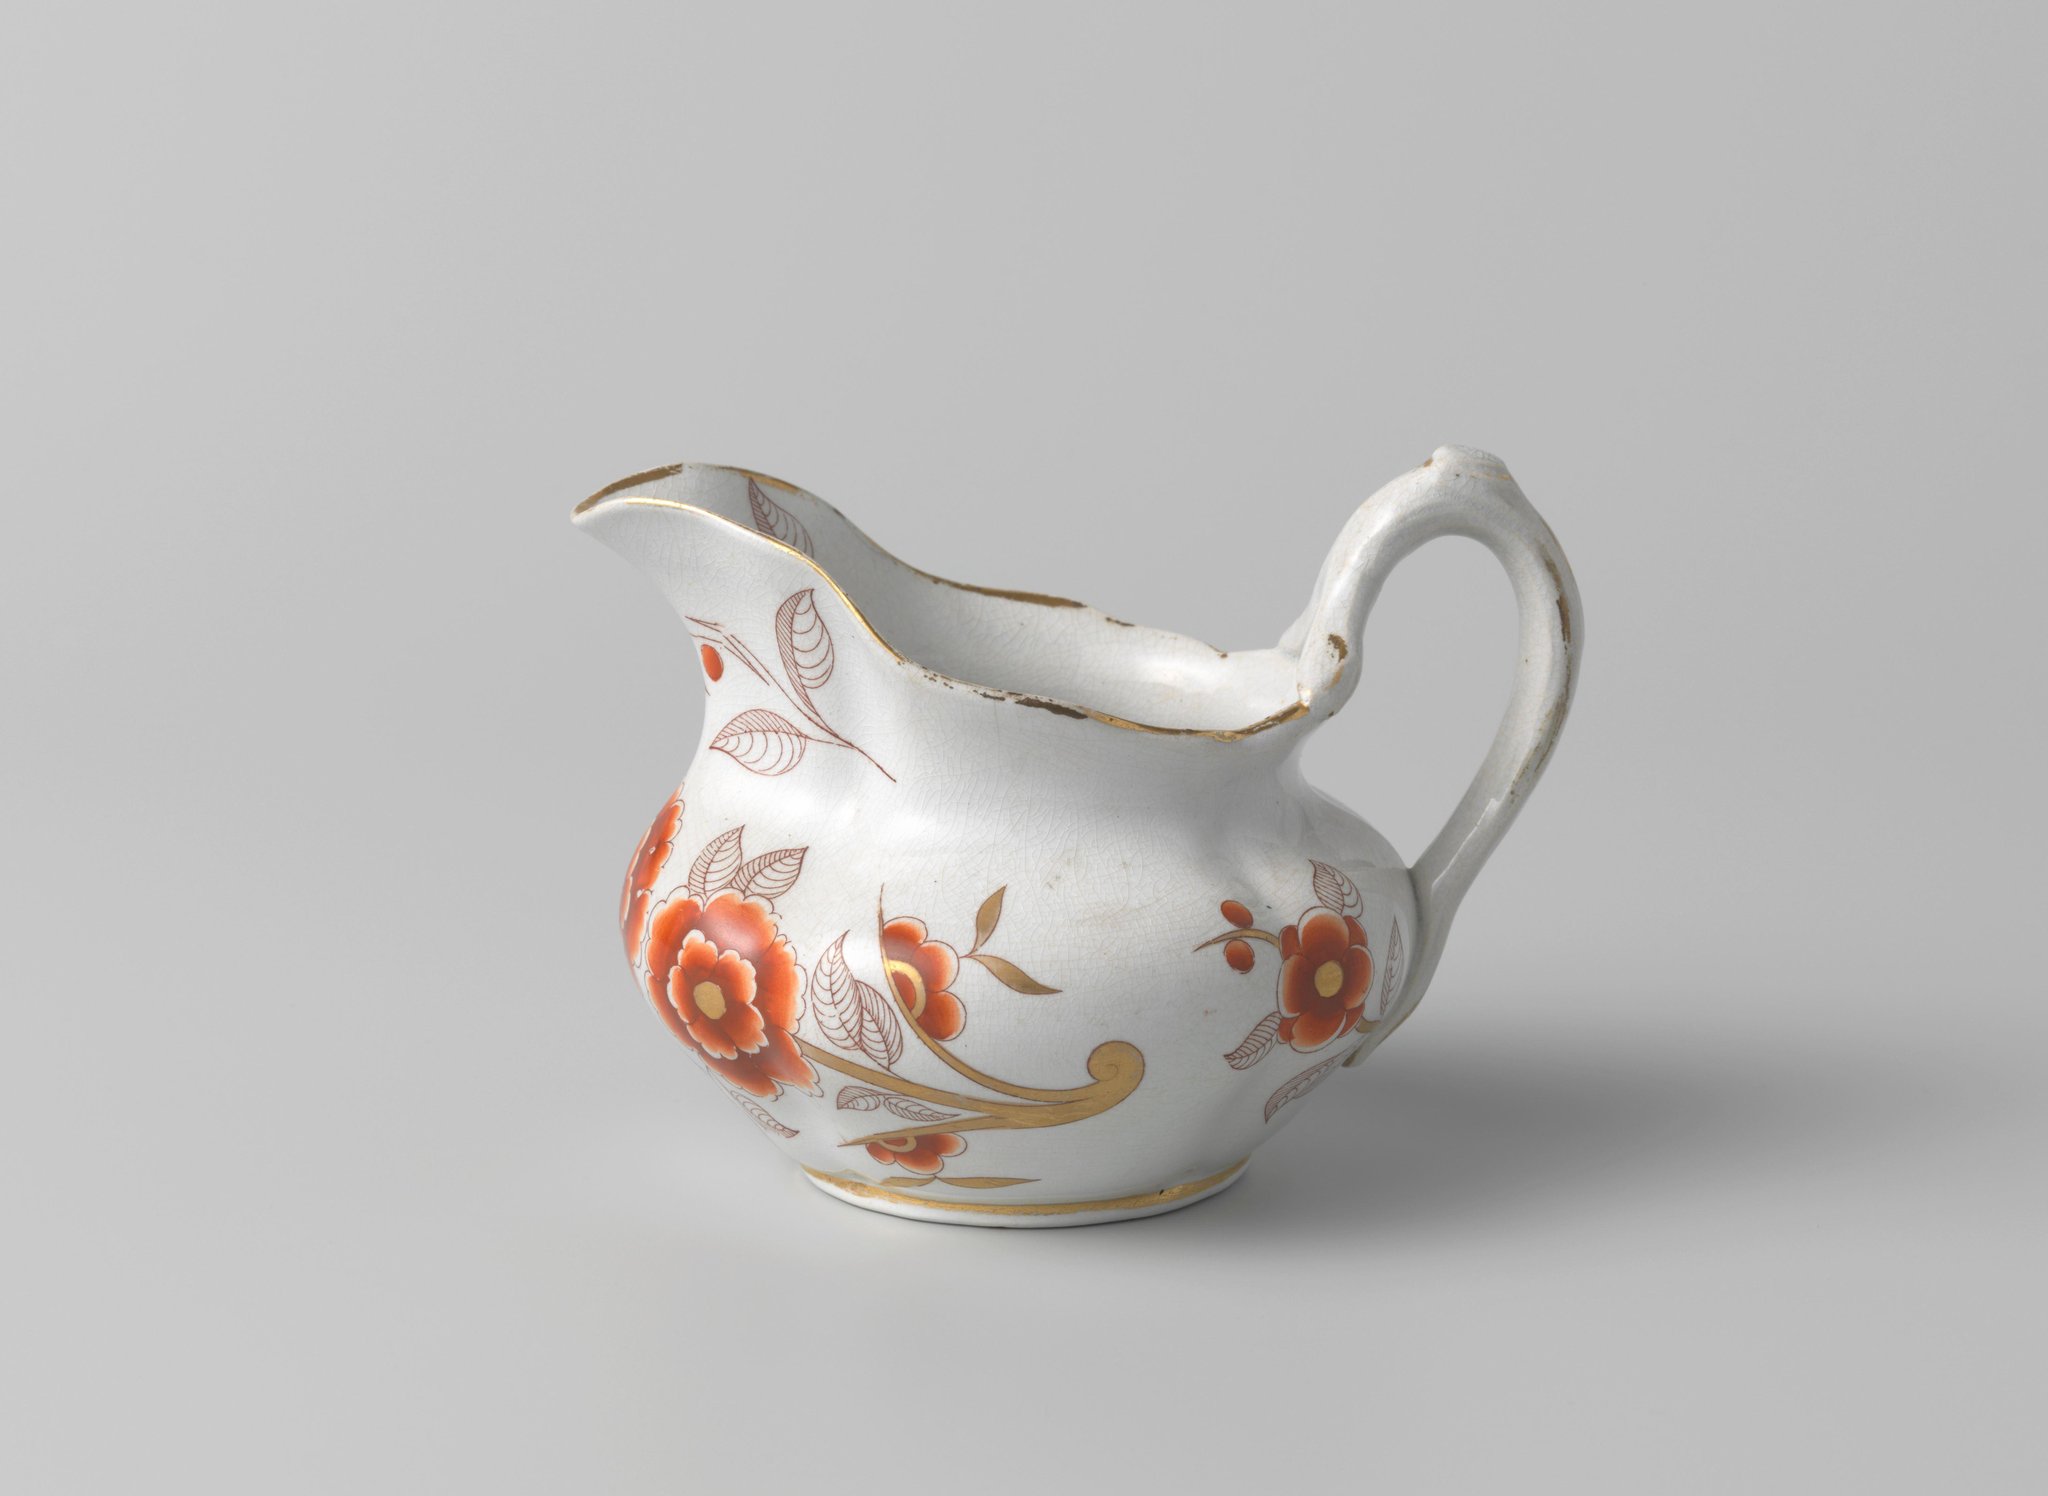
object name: milk jug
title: Melkkan, vierlobbig, met gouden takken met oranje bloemen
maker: petrus regout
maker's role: plateelbakker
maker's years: 1801-1879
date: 1860-1890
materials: creamware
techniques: hogen, muffling, transfer decoration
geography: maastricht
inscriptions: mark: ‘52’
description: Melkkan van aardewerk met bruin transferdecor en moffelkleuren, gehoogd met goud. Het vierlobbig lichaam met gouden takken met oranje bloemen. Het c-vormige oor in de vorm van een tak. Aan de binnenzijde van de schenktuit eveneens een oranje bloem. Langs boven- en onderrand en op het oor resten van goud.